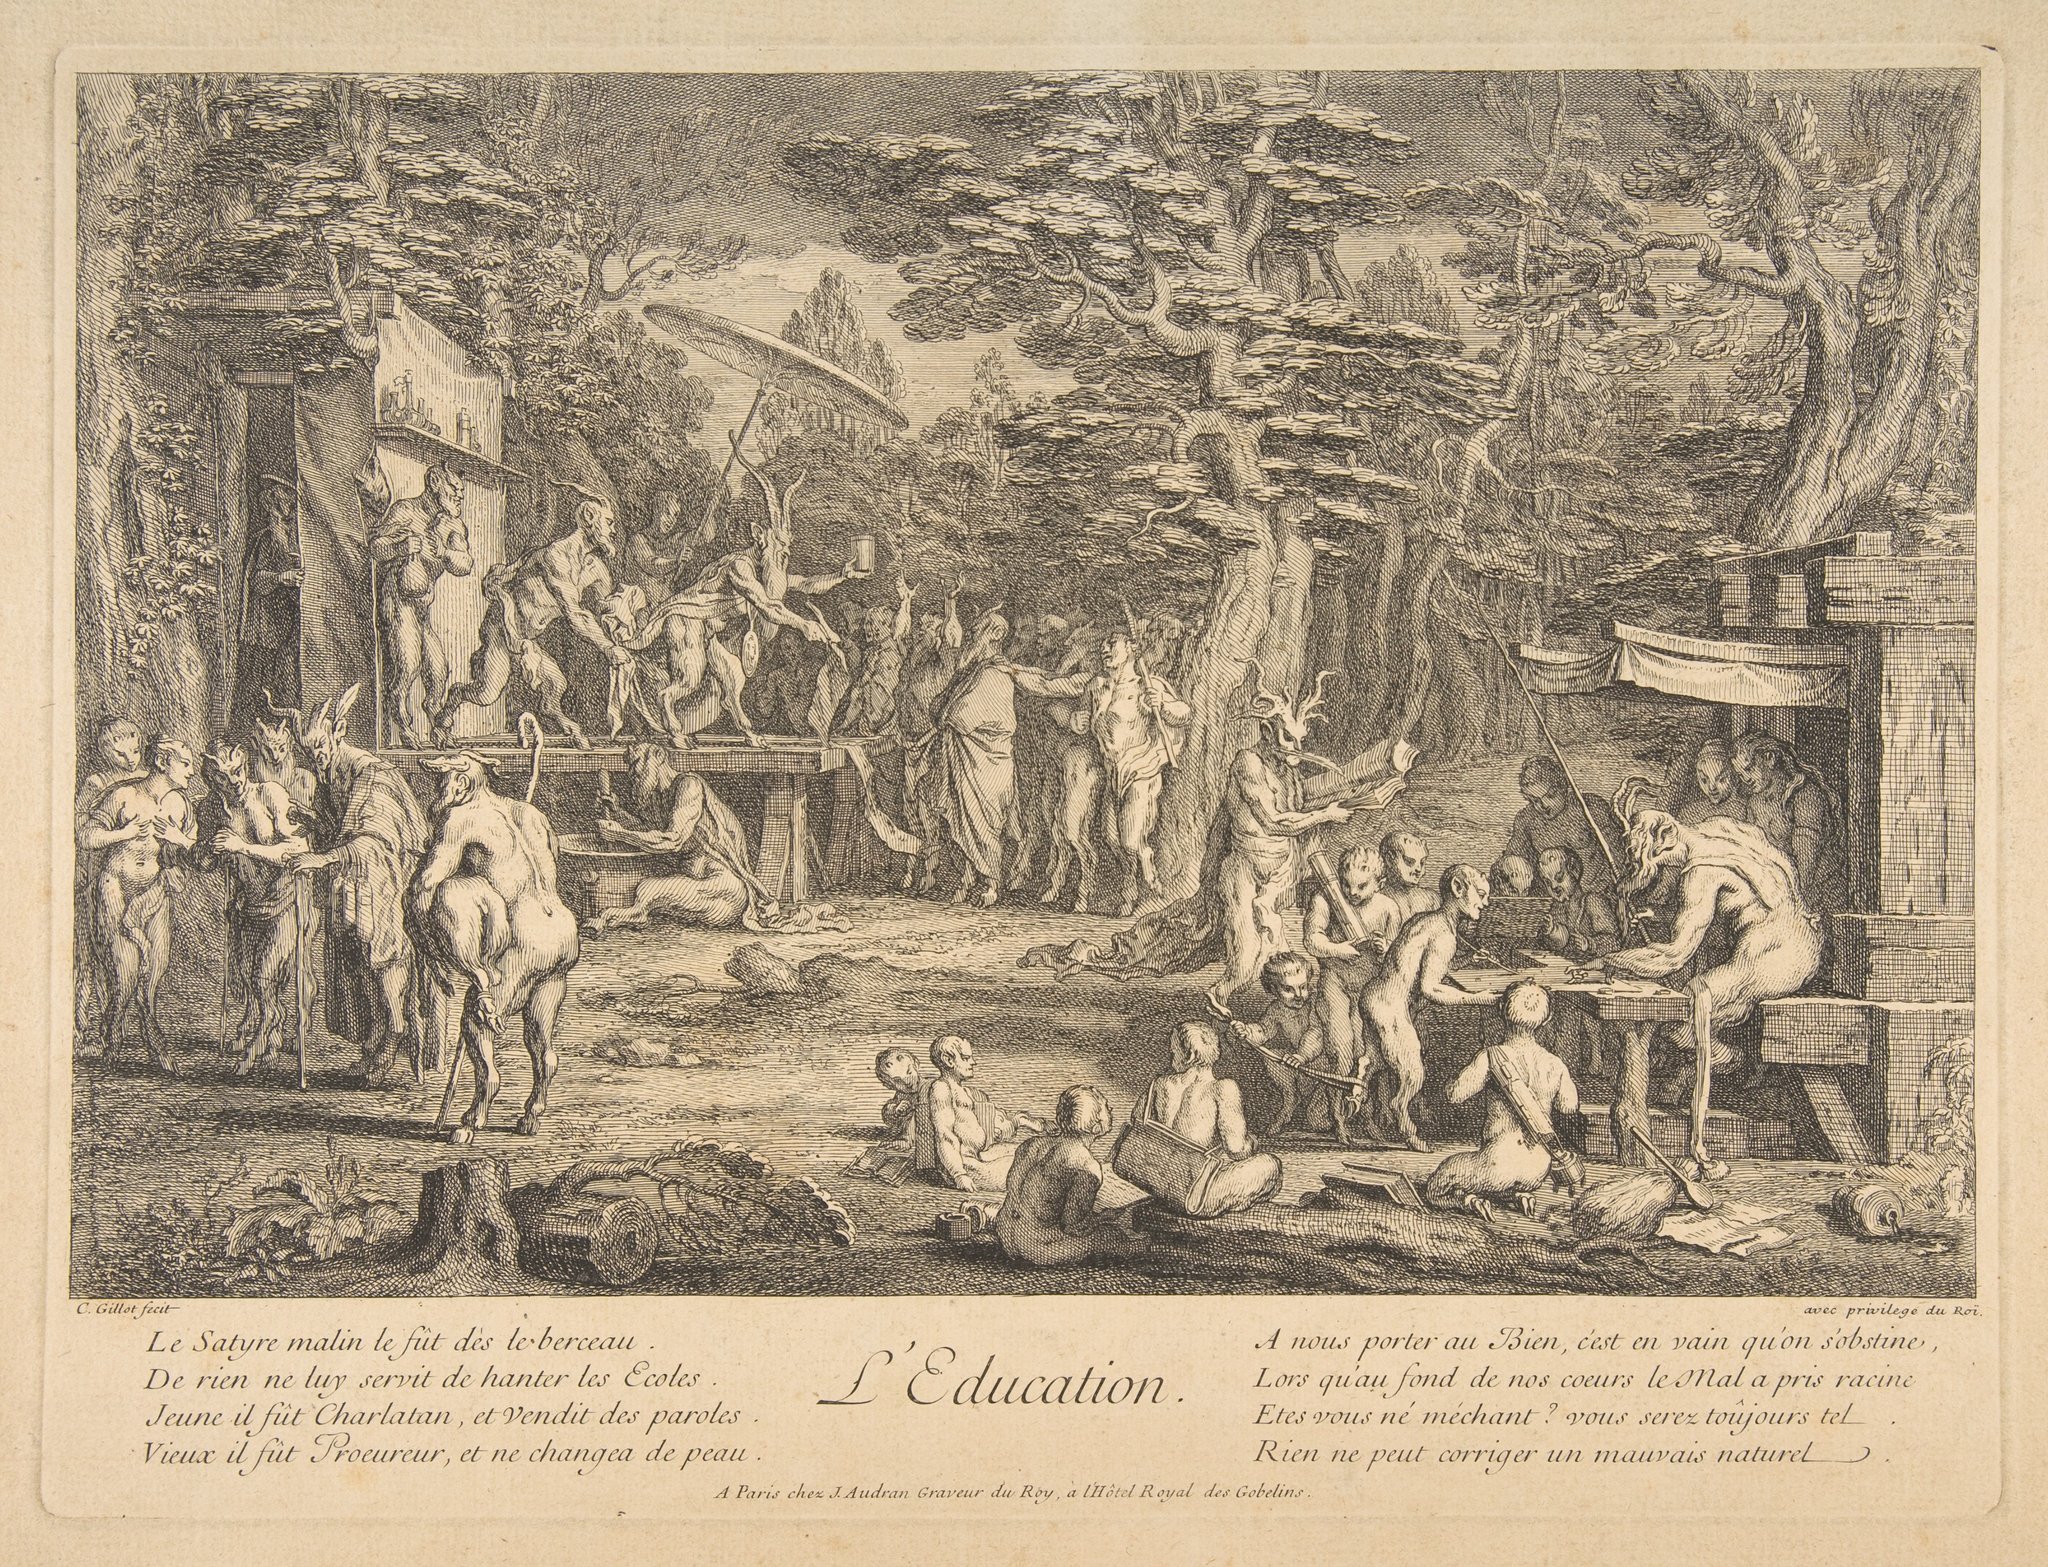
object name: print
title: Education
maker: claude gillot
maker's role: artist and engraver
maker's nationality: french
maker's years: 1673-1722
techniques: etching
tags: education